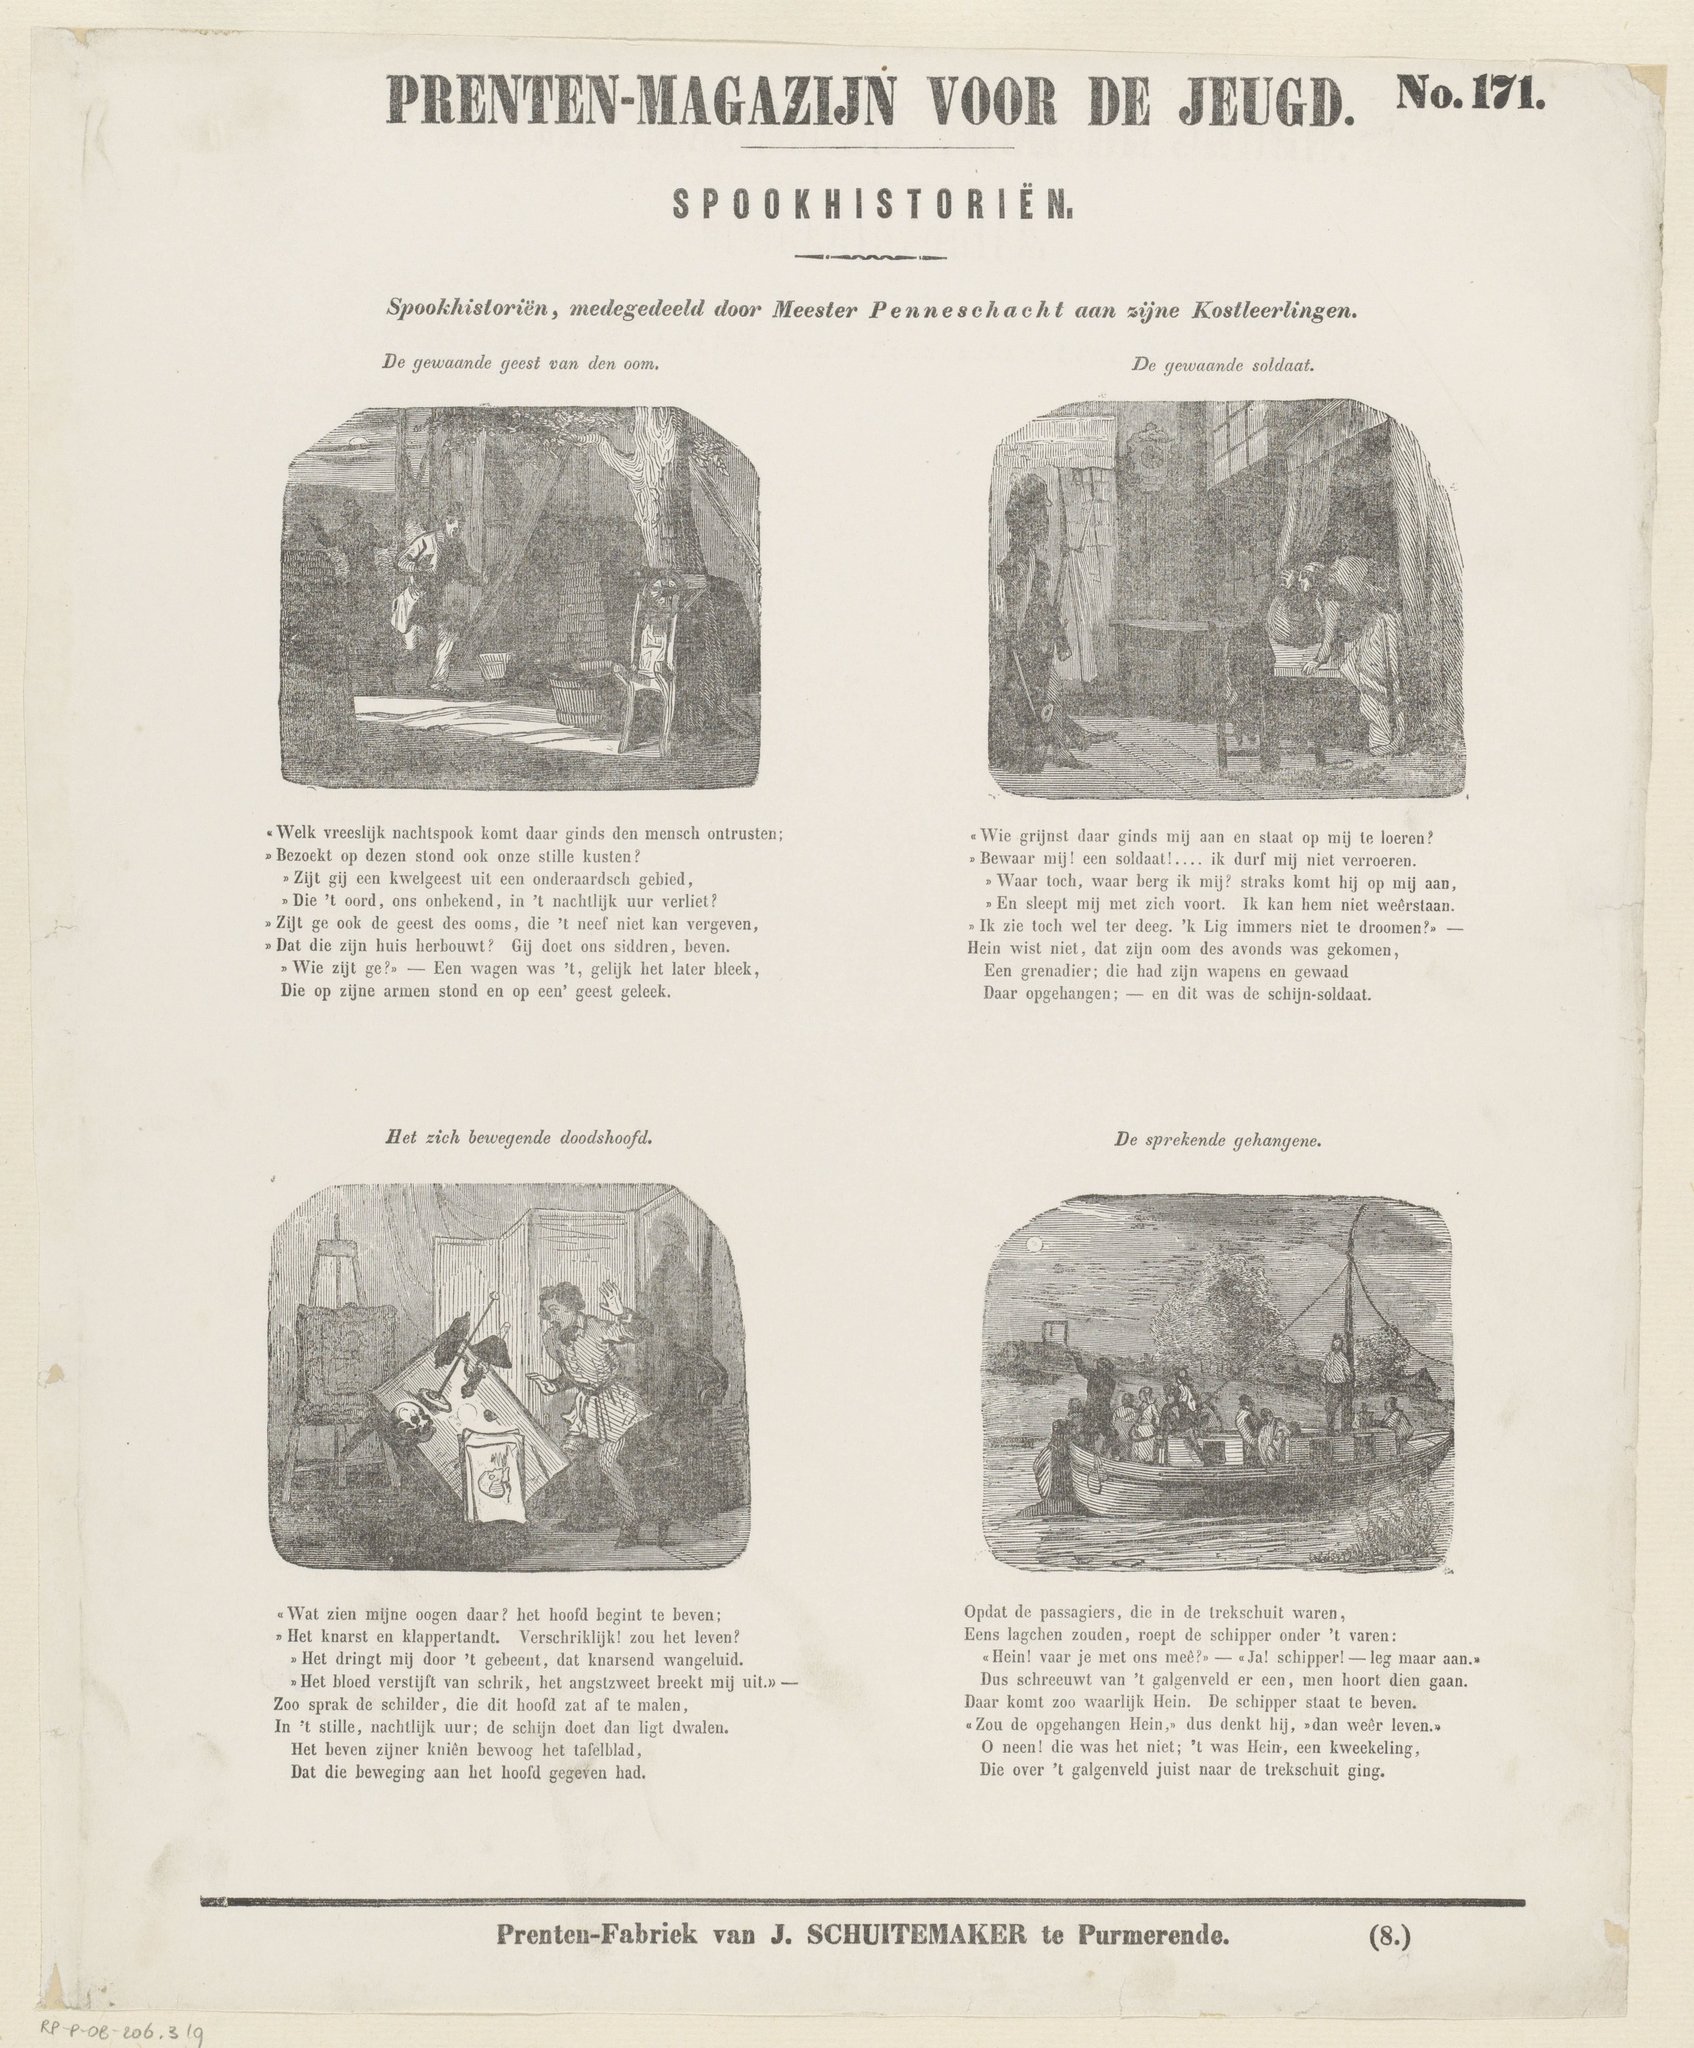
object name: print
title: Spookhistoriën, medegedeeld door meester Penneschacht aan zijne kostleerlingen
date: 1850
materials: paper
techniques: letterpress printing, engraving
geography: purmerend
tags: tales and fairy tales, spirit, ghost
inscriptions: collector's mark: Lugt 2760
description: Na voltooiing van de acht jaargangen van de reeks 'Prenten-magazijn voor de jeugd' in 1850 heeft Jan Schuitemaker al deze prenten heruitgegeven en omgenummerd als nr. 1 t/m 192. De oorspronkelijke jaargang wordt telkens nog vermeld rechtsonder op de prent. Binnen de jaargangen zijn prenten van hetzelfde thema in clusters van vier achter elkaar gezet.